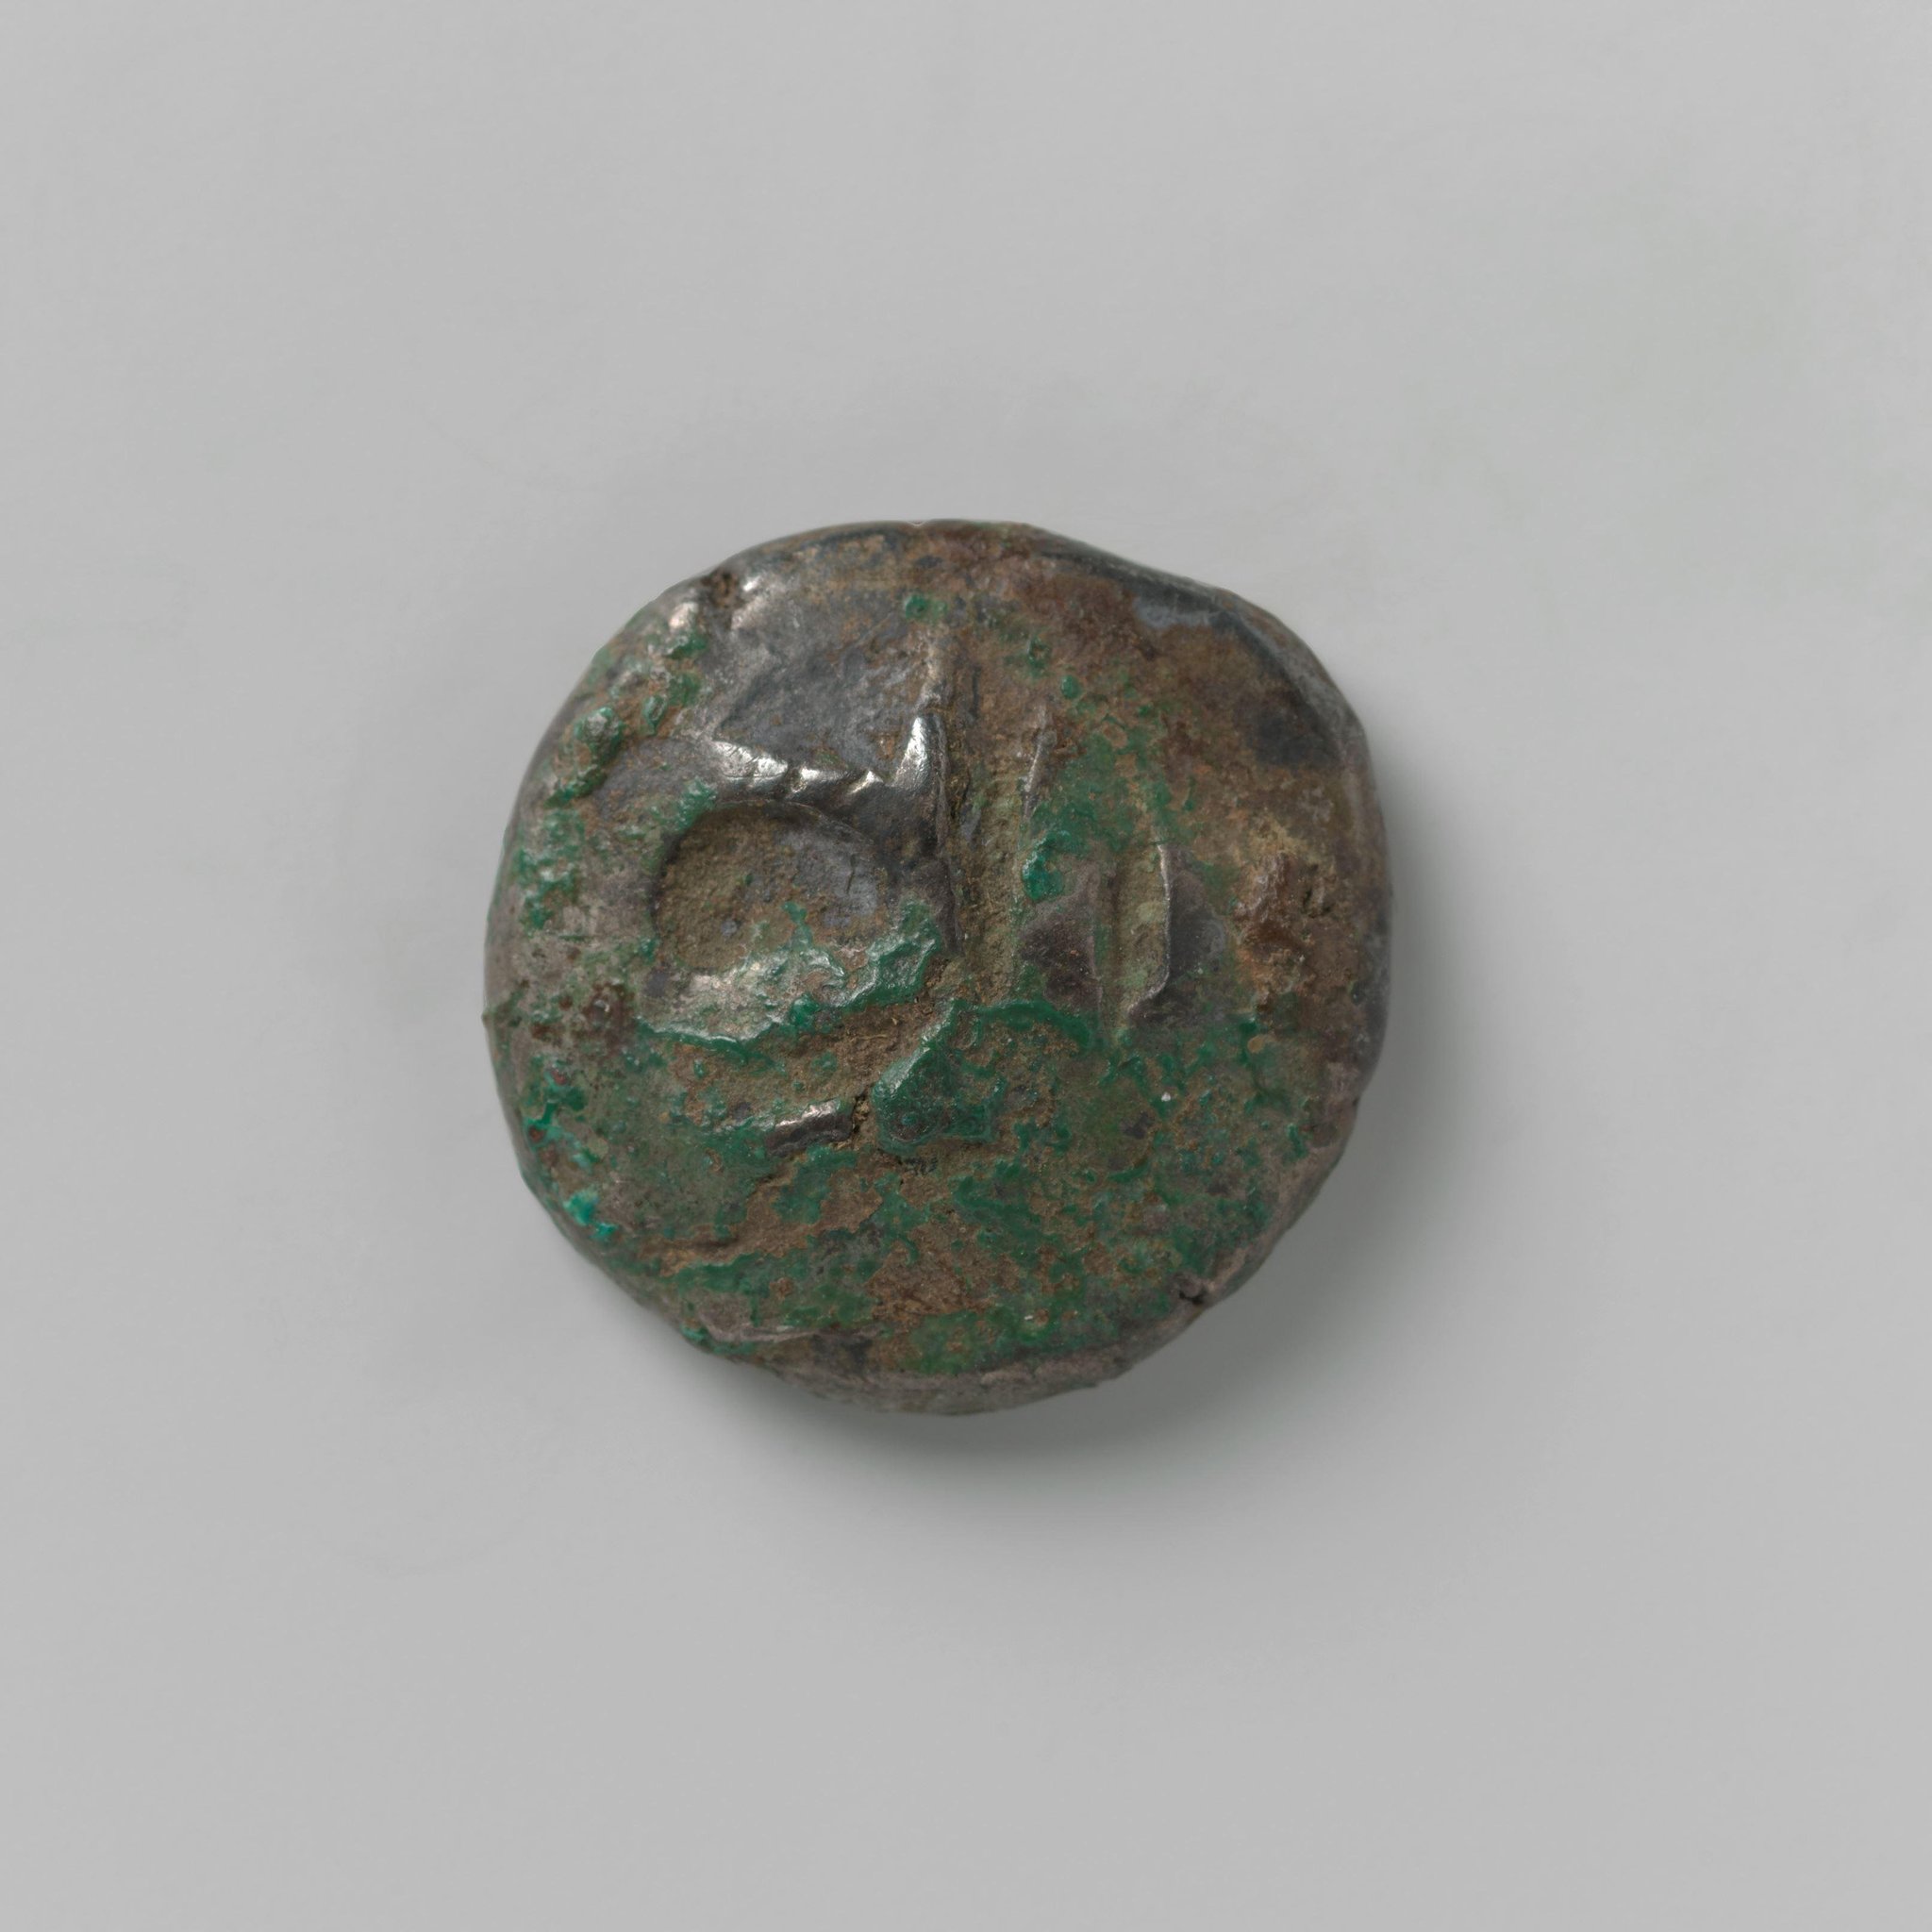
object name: coin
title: Java, koninkrijk Majopahit, djampel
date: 1290-1520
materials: silver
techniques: striking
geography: java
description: Zilveren schotelvormige munt. Voorzijde: letterteken in devanagari-schrift [maa?]. Keerzijde, figuratie [bloem?].